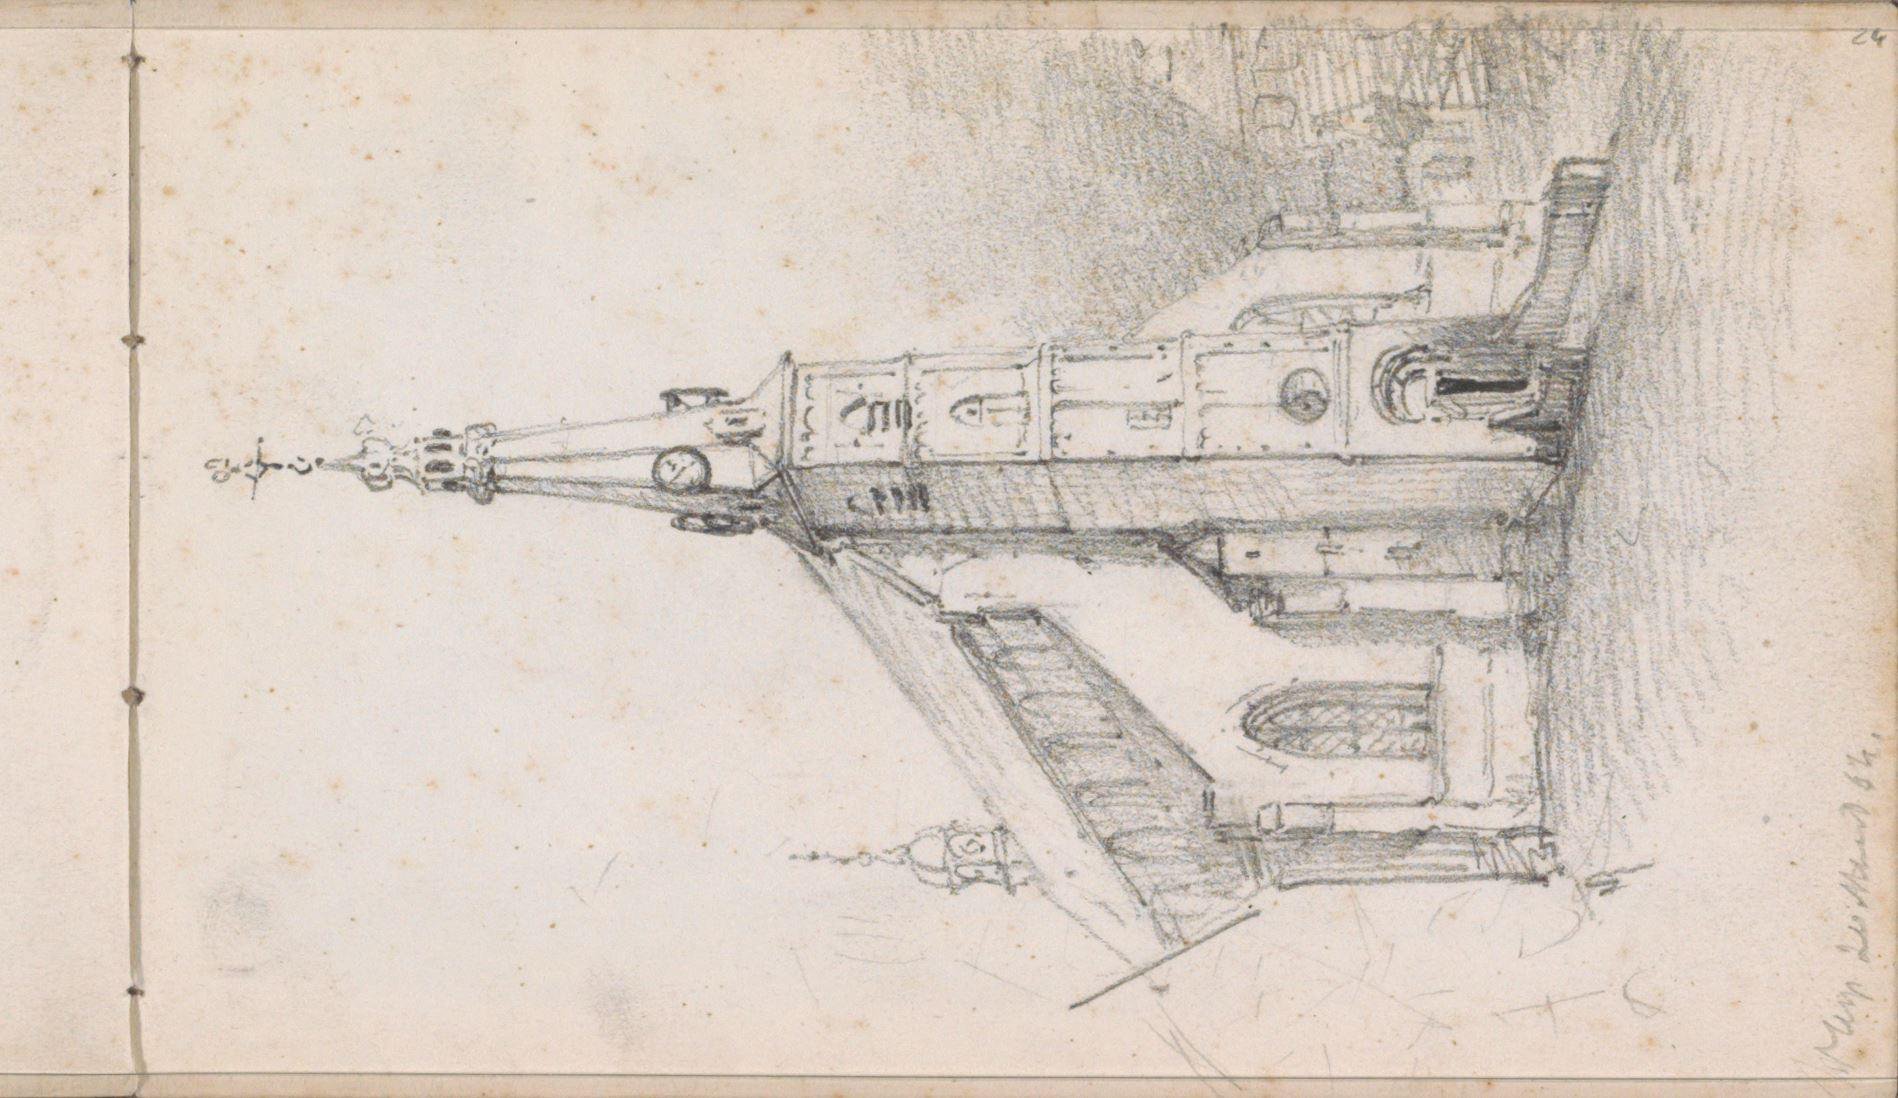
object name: sketchbook leaf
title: Grote Kerk te Weesp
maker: maria vos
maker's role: draughtsman, painter, print maker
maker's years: 1824-1906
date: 1863-1864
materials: paper, pencil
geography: weesp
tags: church (exterior)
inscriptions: date and inscription: ‘[...] 20 Maart 64.’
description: Blad 24 recto uit een schetsboek met 41 bladen.